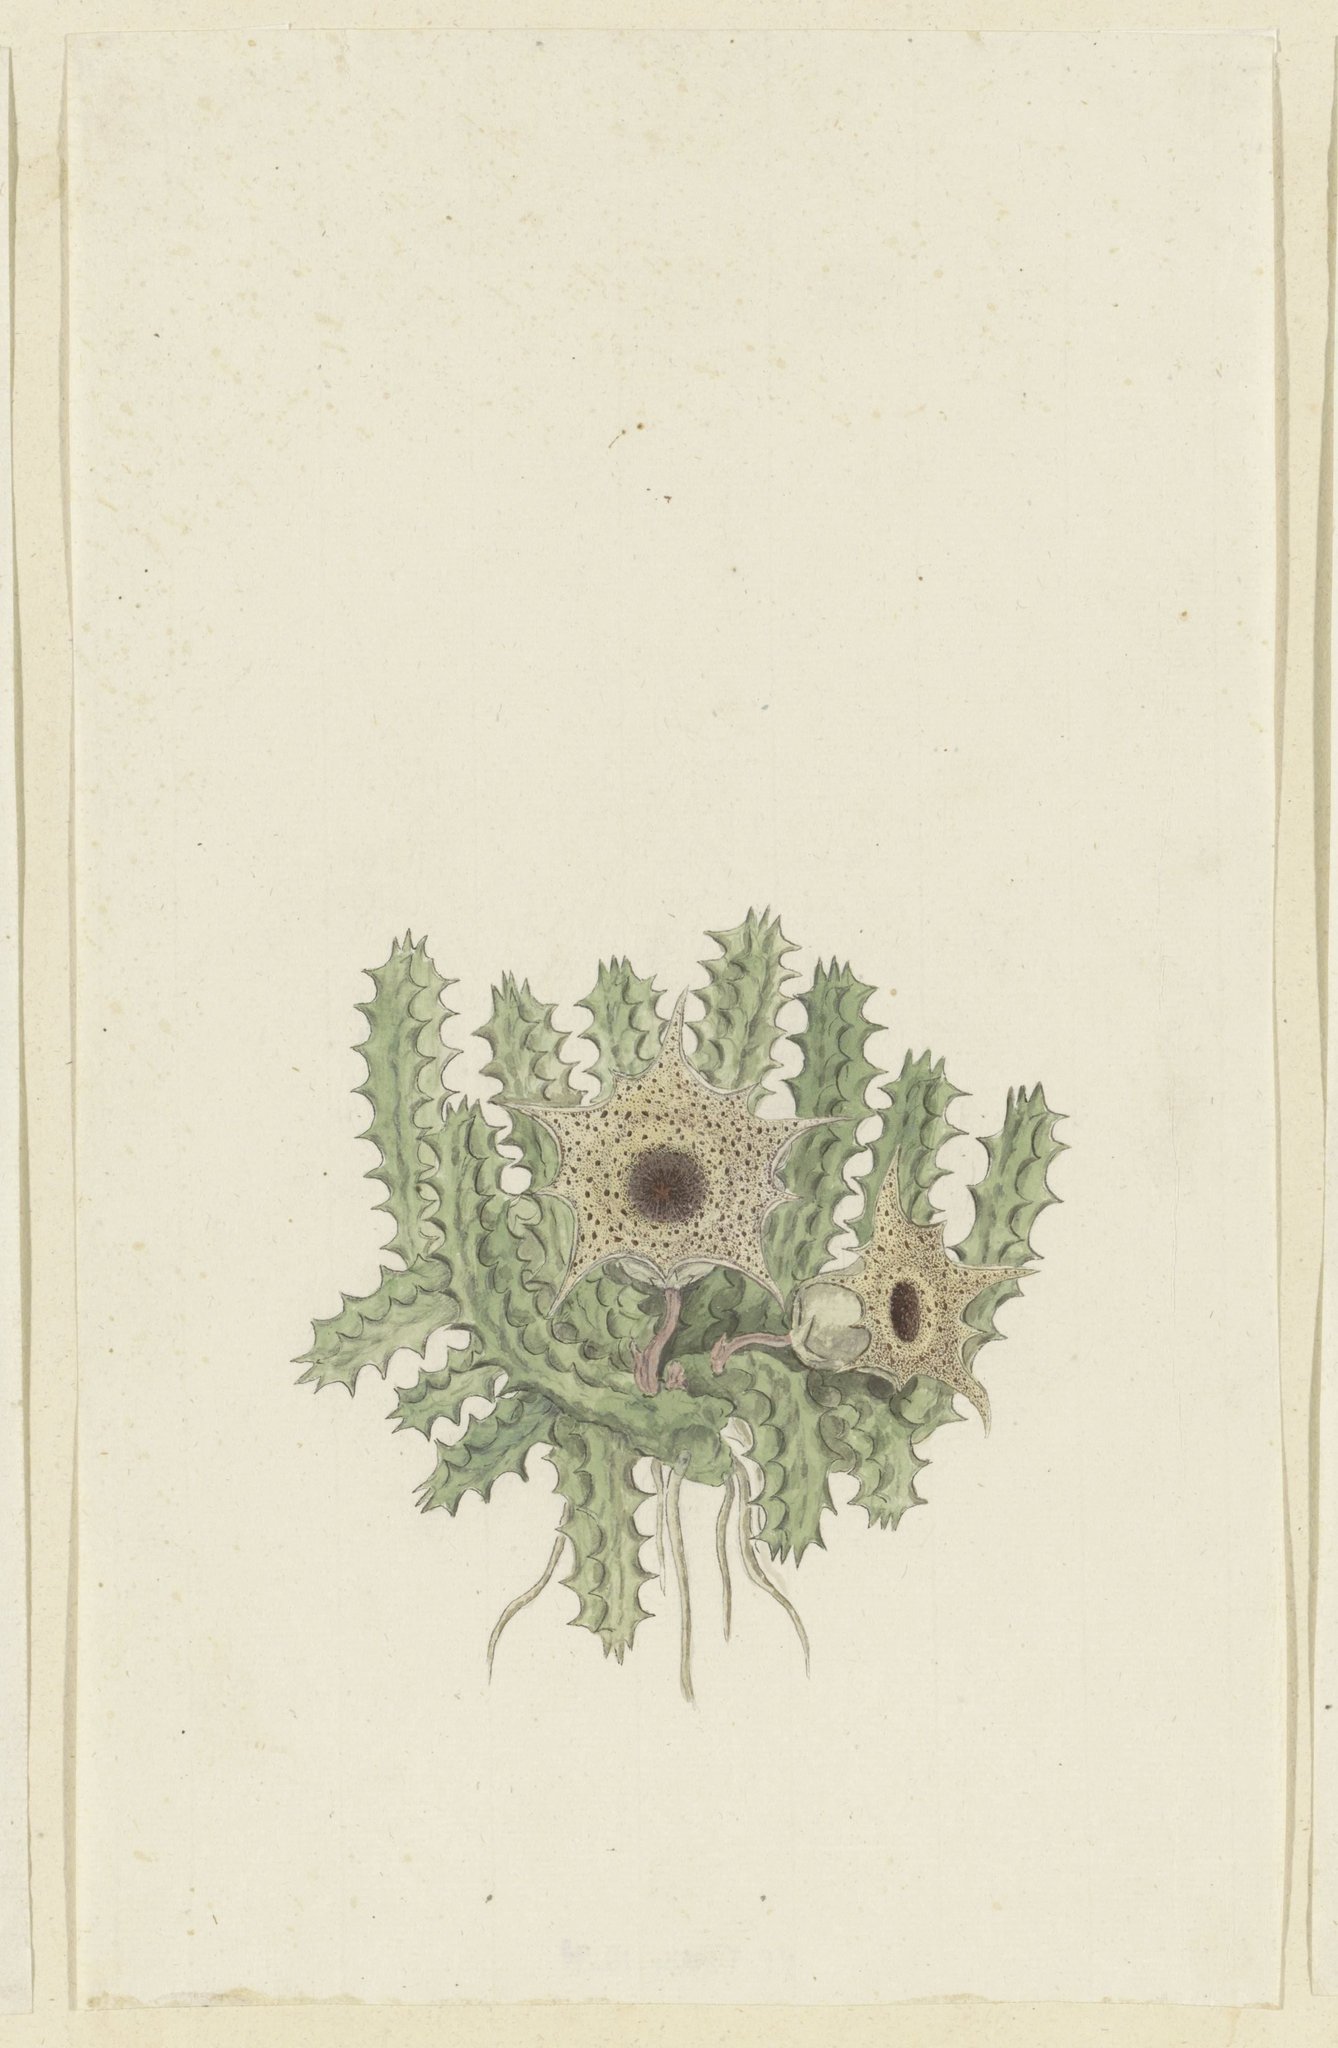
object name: album leaf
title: Huernia barbata (Masson) Haw.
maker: robert jacob gordon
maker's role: draughtsman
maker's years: 1743-1795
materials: chalk, ink, paper, pencil, watercolor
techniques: brush, pen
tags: plants; vegetation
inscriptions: annotation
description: De tekening is gemaakt voor of tijdens een van Gordon's vier expedities door de Kaapprovincie, van oktober 1777 tot maart 1786. Sommige (soort)namen kunnen zijn gewijzigd, gezien reorganisatie in plantentaxonomie gedurende de afgelopen jaren.